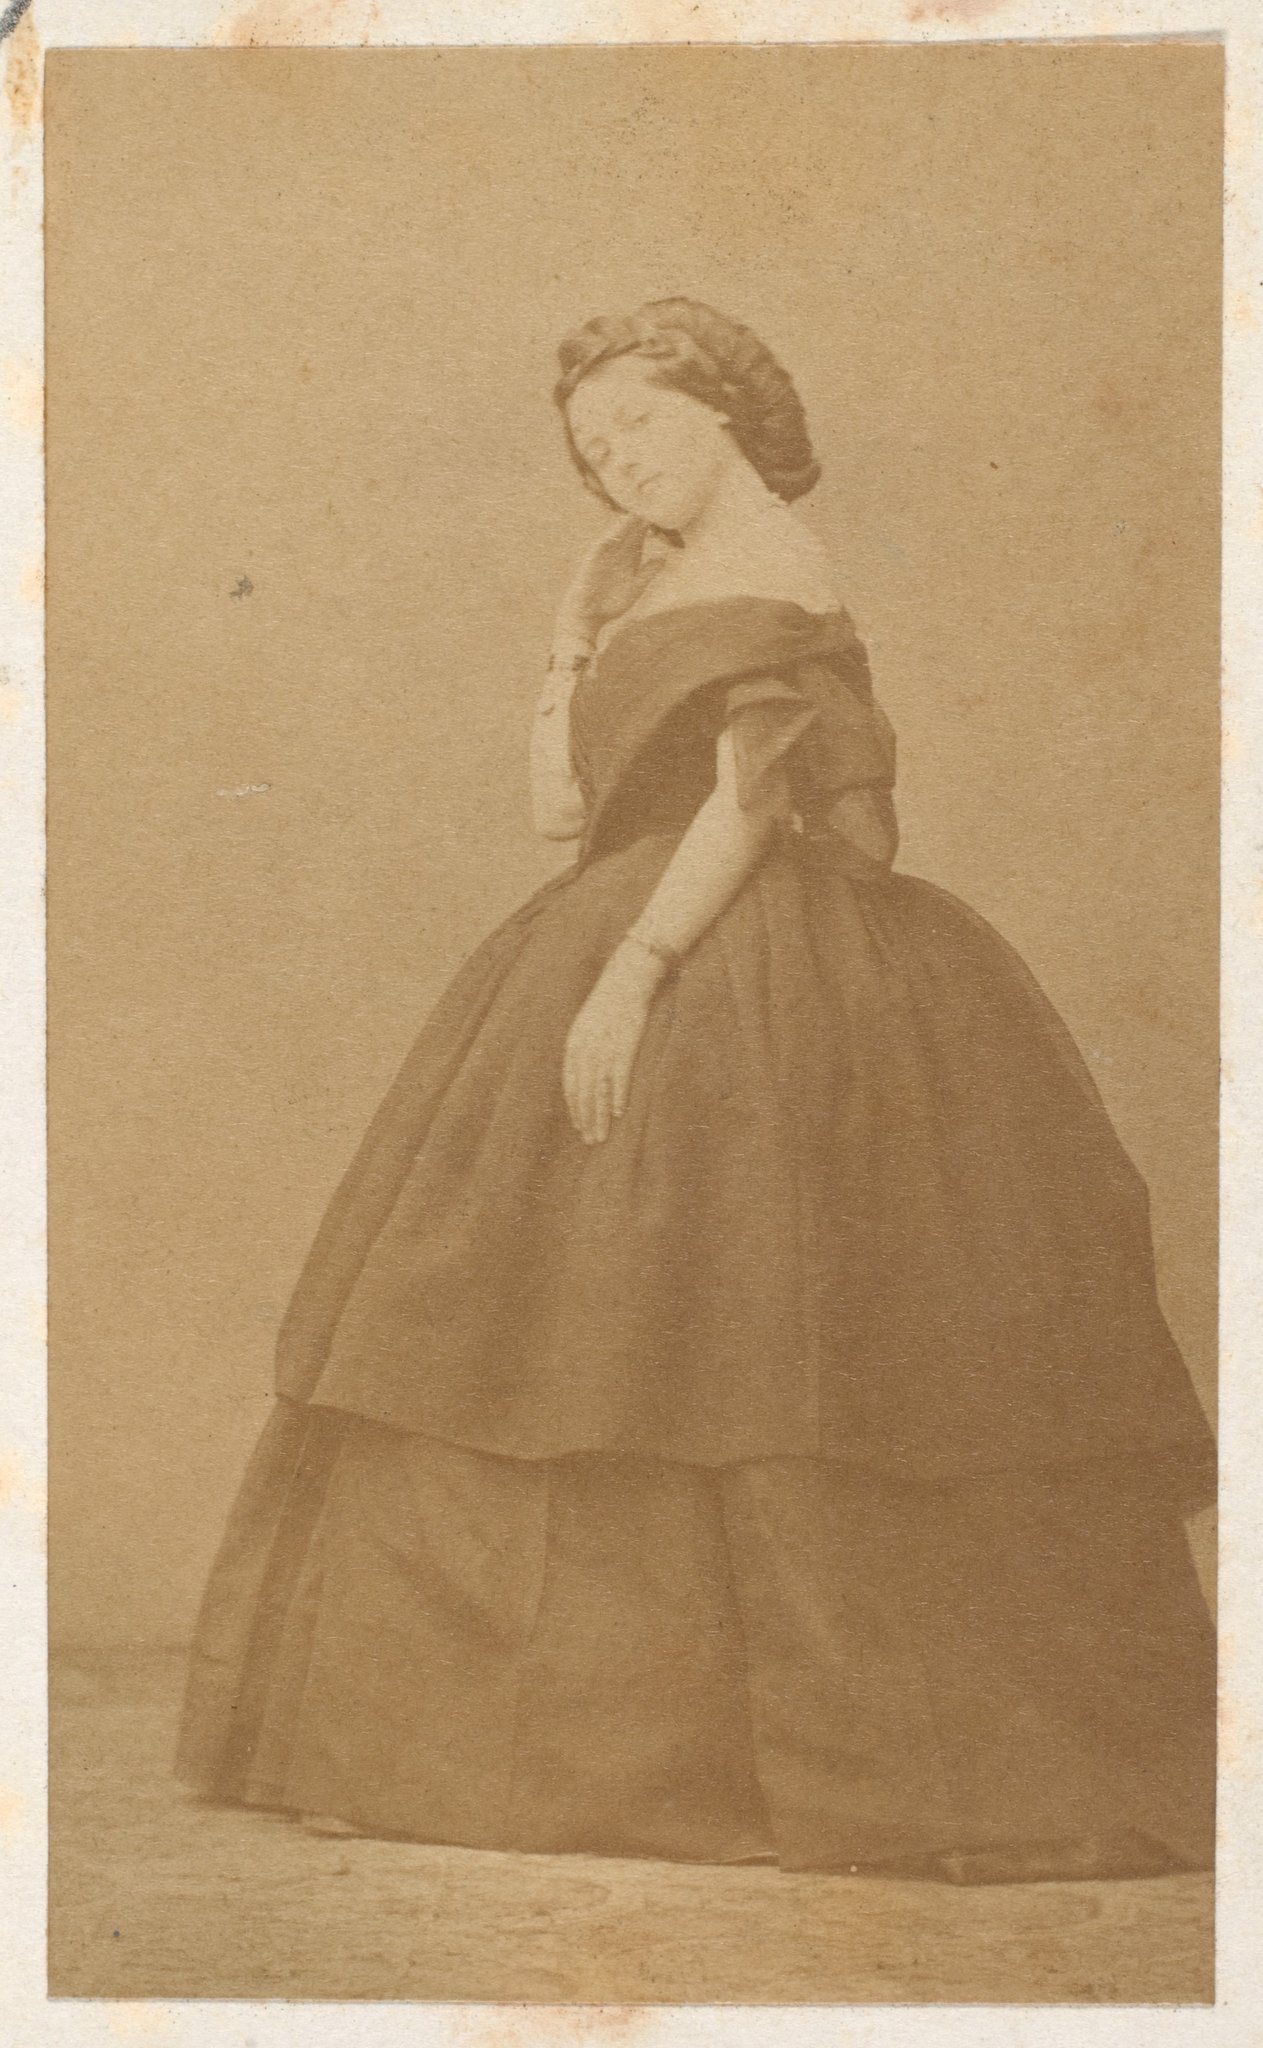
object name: photograph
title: Aux écoutes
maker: pierre-louis pierson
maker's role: artist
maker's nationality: french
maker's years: 1822-1913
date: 1860-1869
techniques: albumen silver print, glass negative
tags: portraits,women